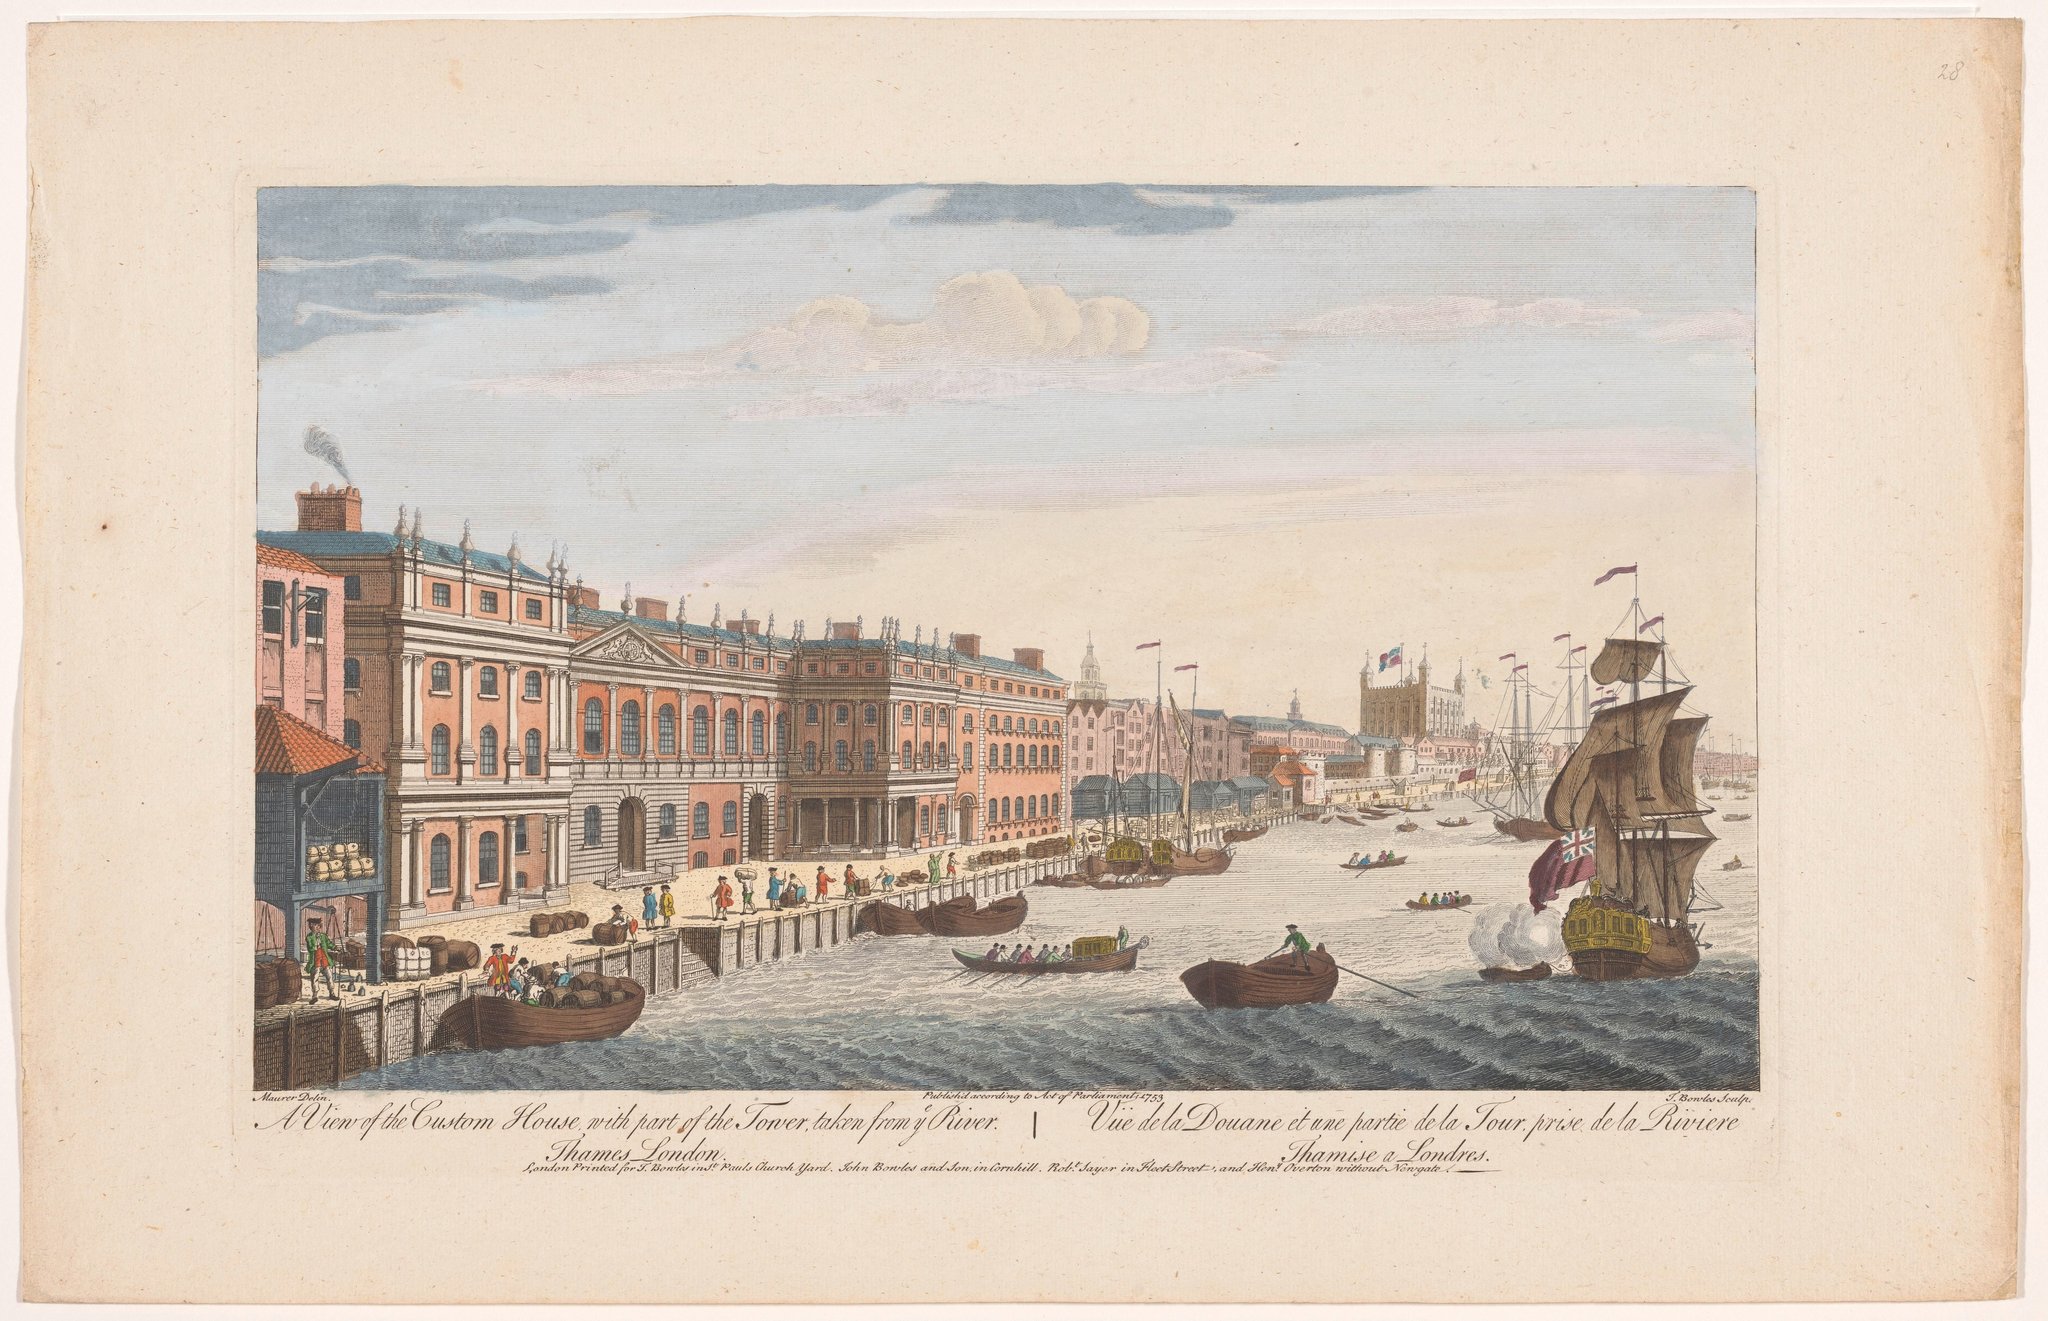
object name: opticaprent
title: Gezicht op het Custom House aan de rivier de Theems te Londen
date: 1753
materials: paper, watercolor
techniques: brush, etching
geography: london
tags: customs, canals, waters (in city) (+ city(-scape) with figures, staffage), thames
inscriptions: date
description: De serie “Londen” bevat 52 prenten met de nummers 1-52, waarvan dit nummer 28 is.